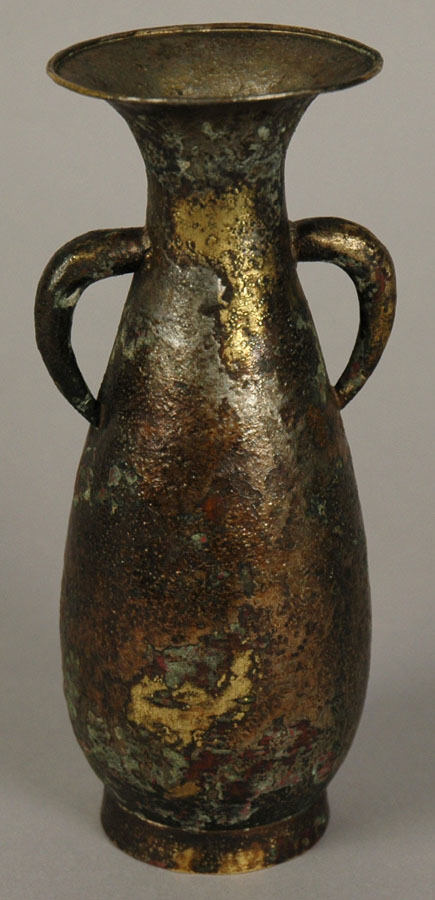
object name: vase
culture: japanese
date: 1801-1900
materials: bronze